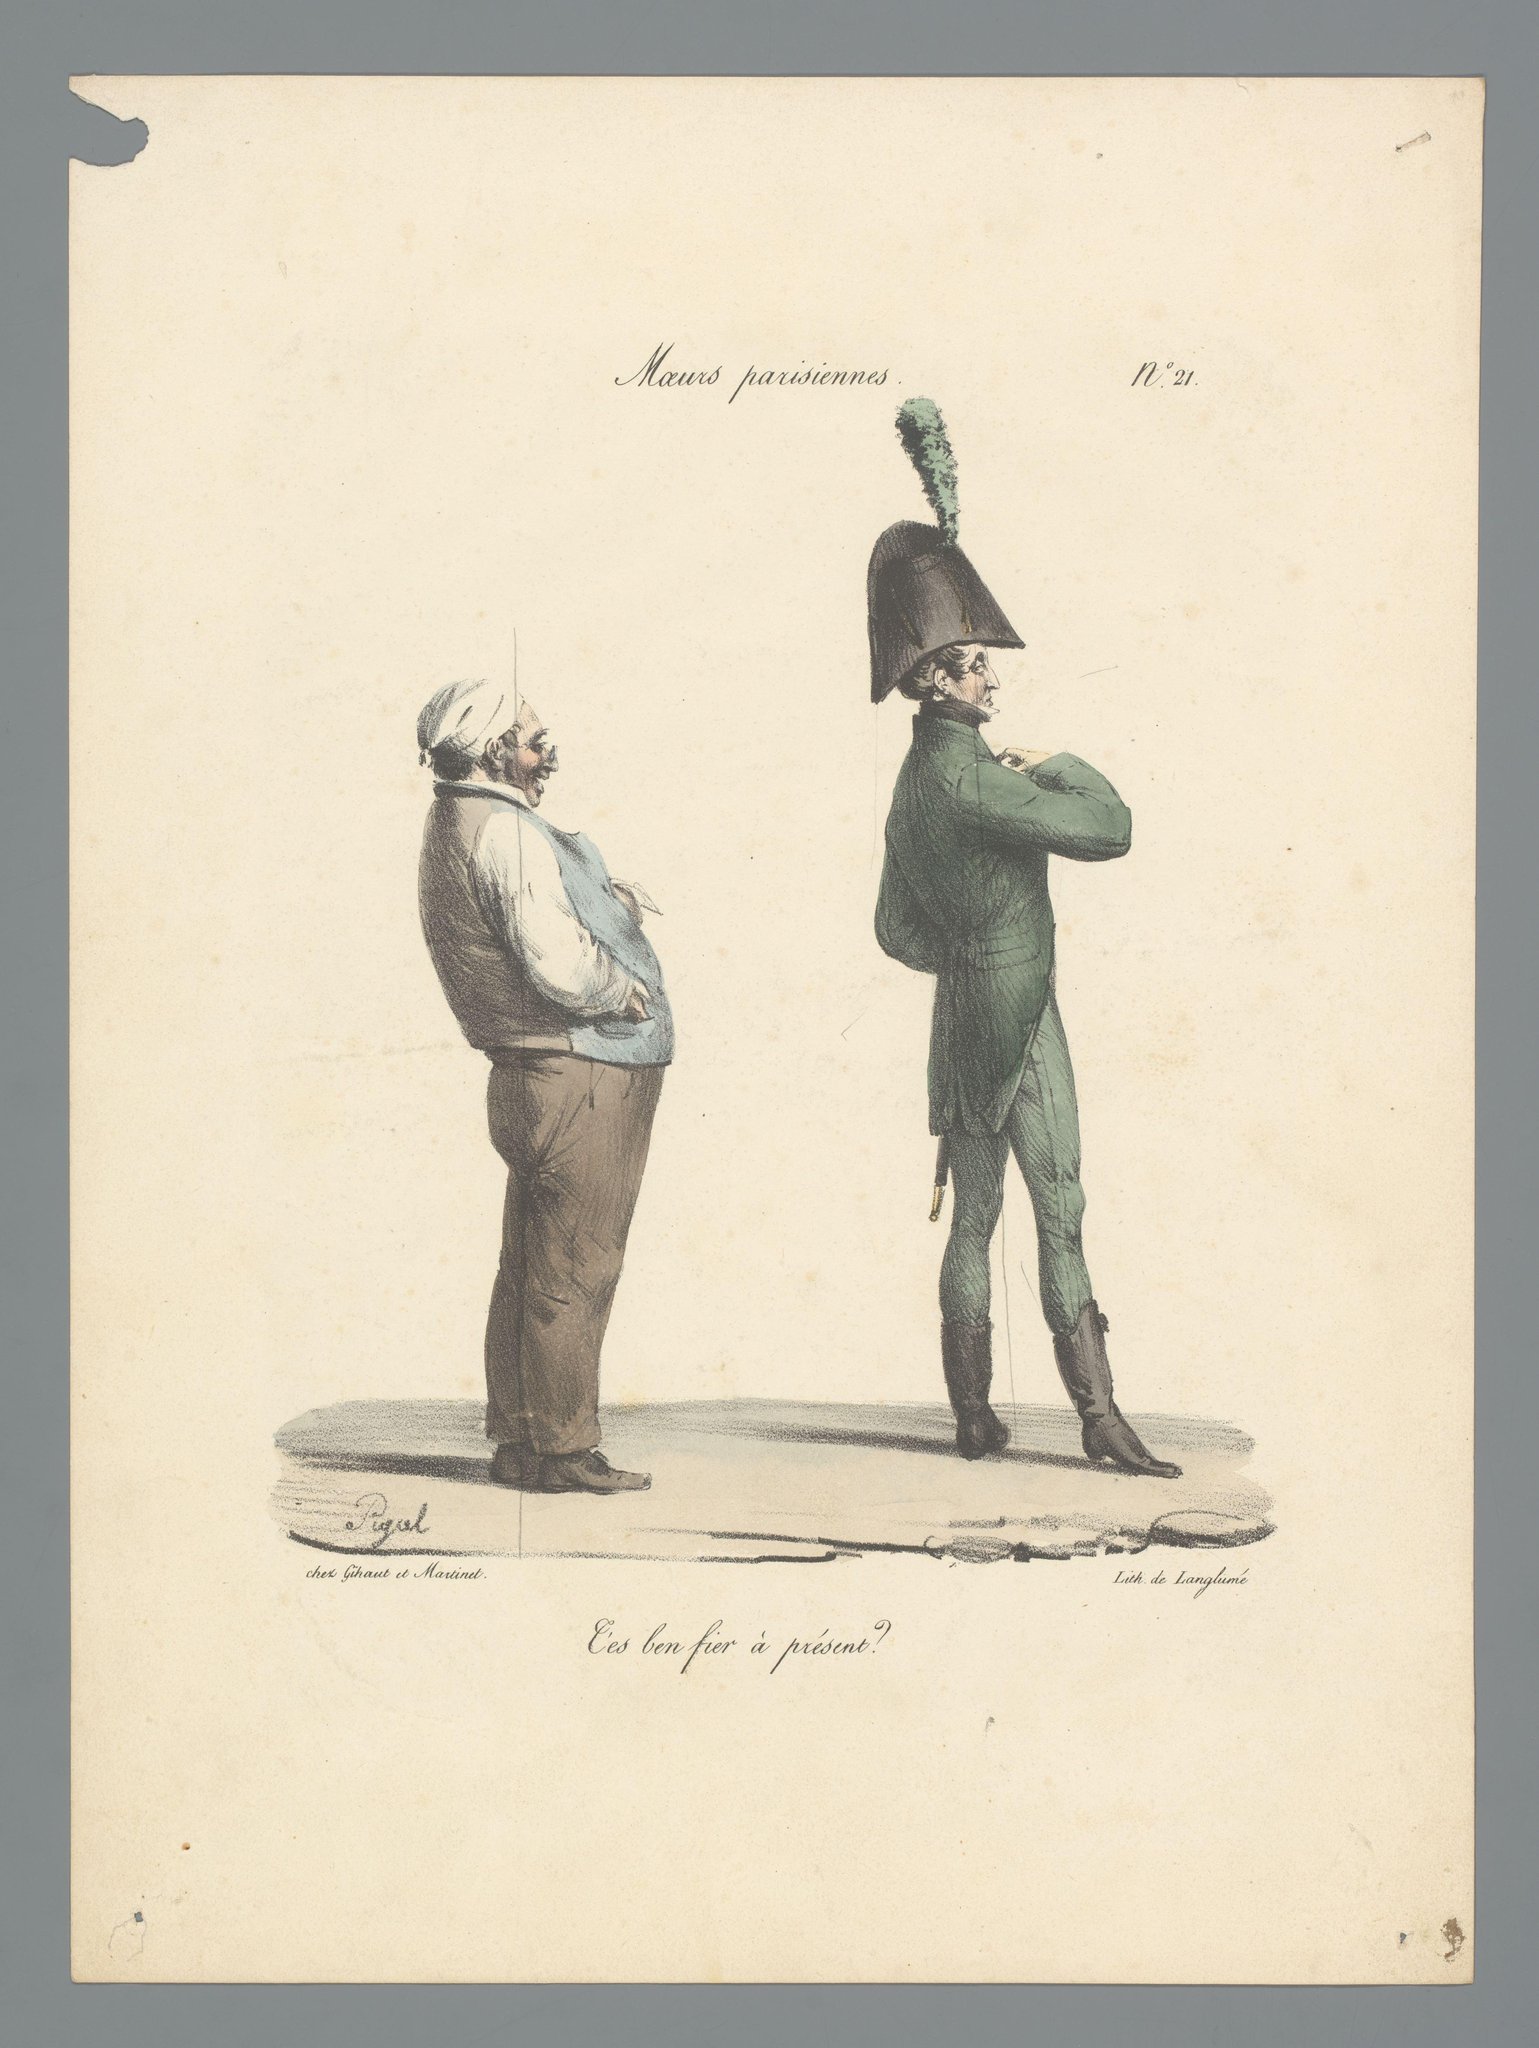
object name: print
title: T'es ben fier à présent?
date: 1825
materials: paper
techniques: hand coloring, lithograph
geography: paris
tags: adult man, clothes for special purposes, old man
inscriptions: collector's mark: Lugt 2228